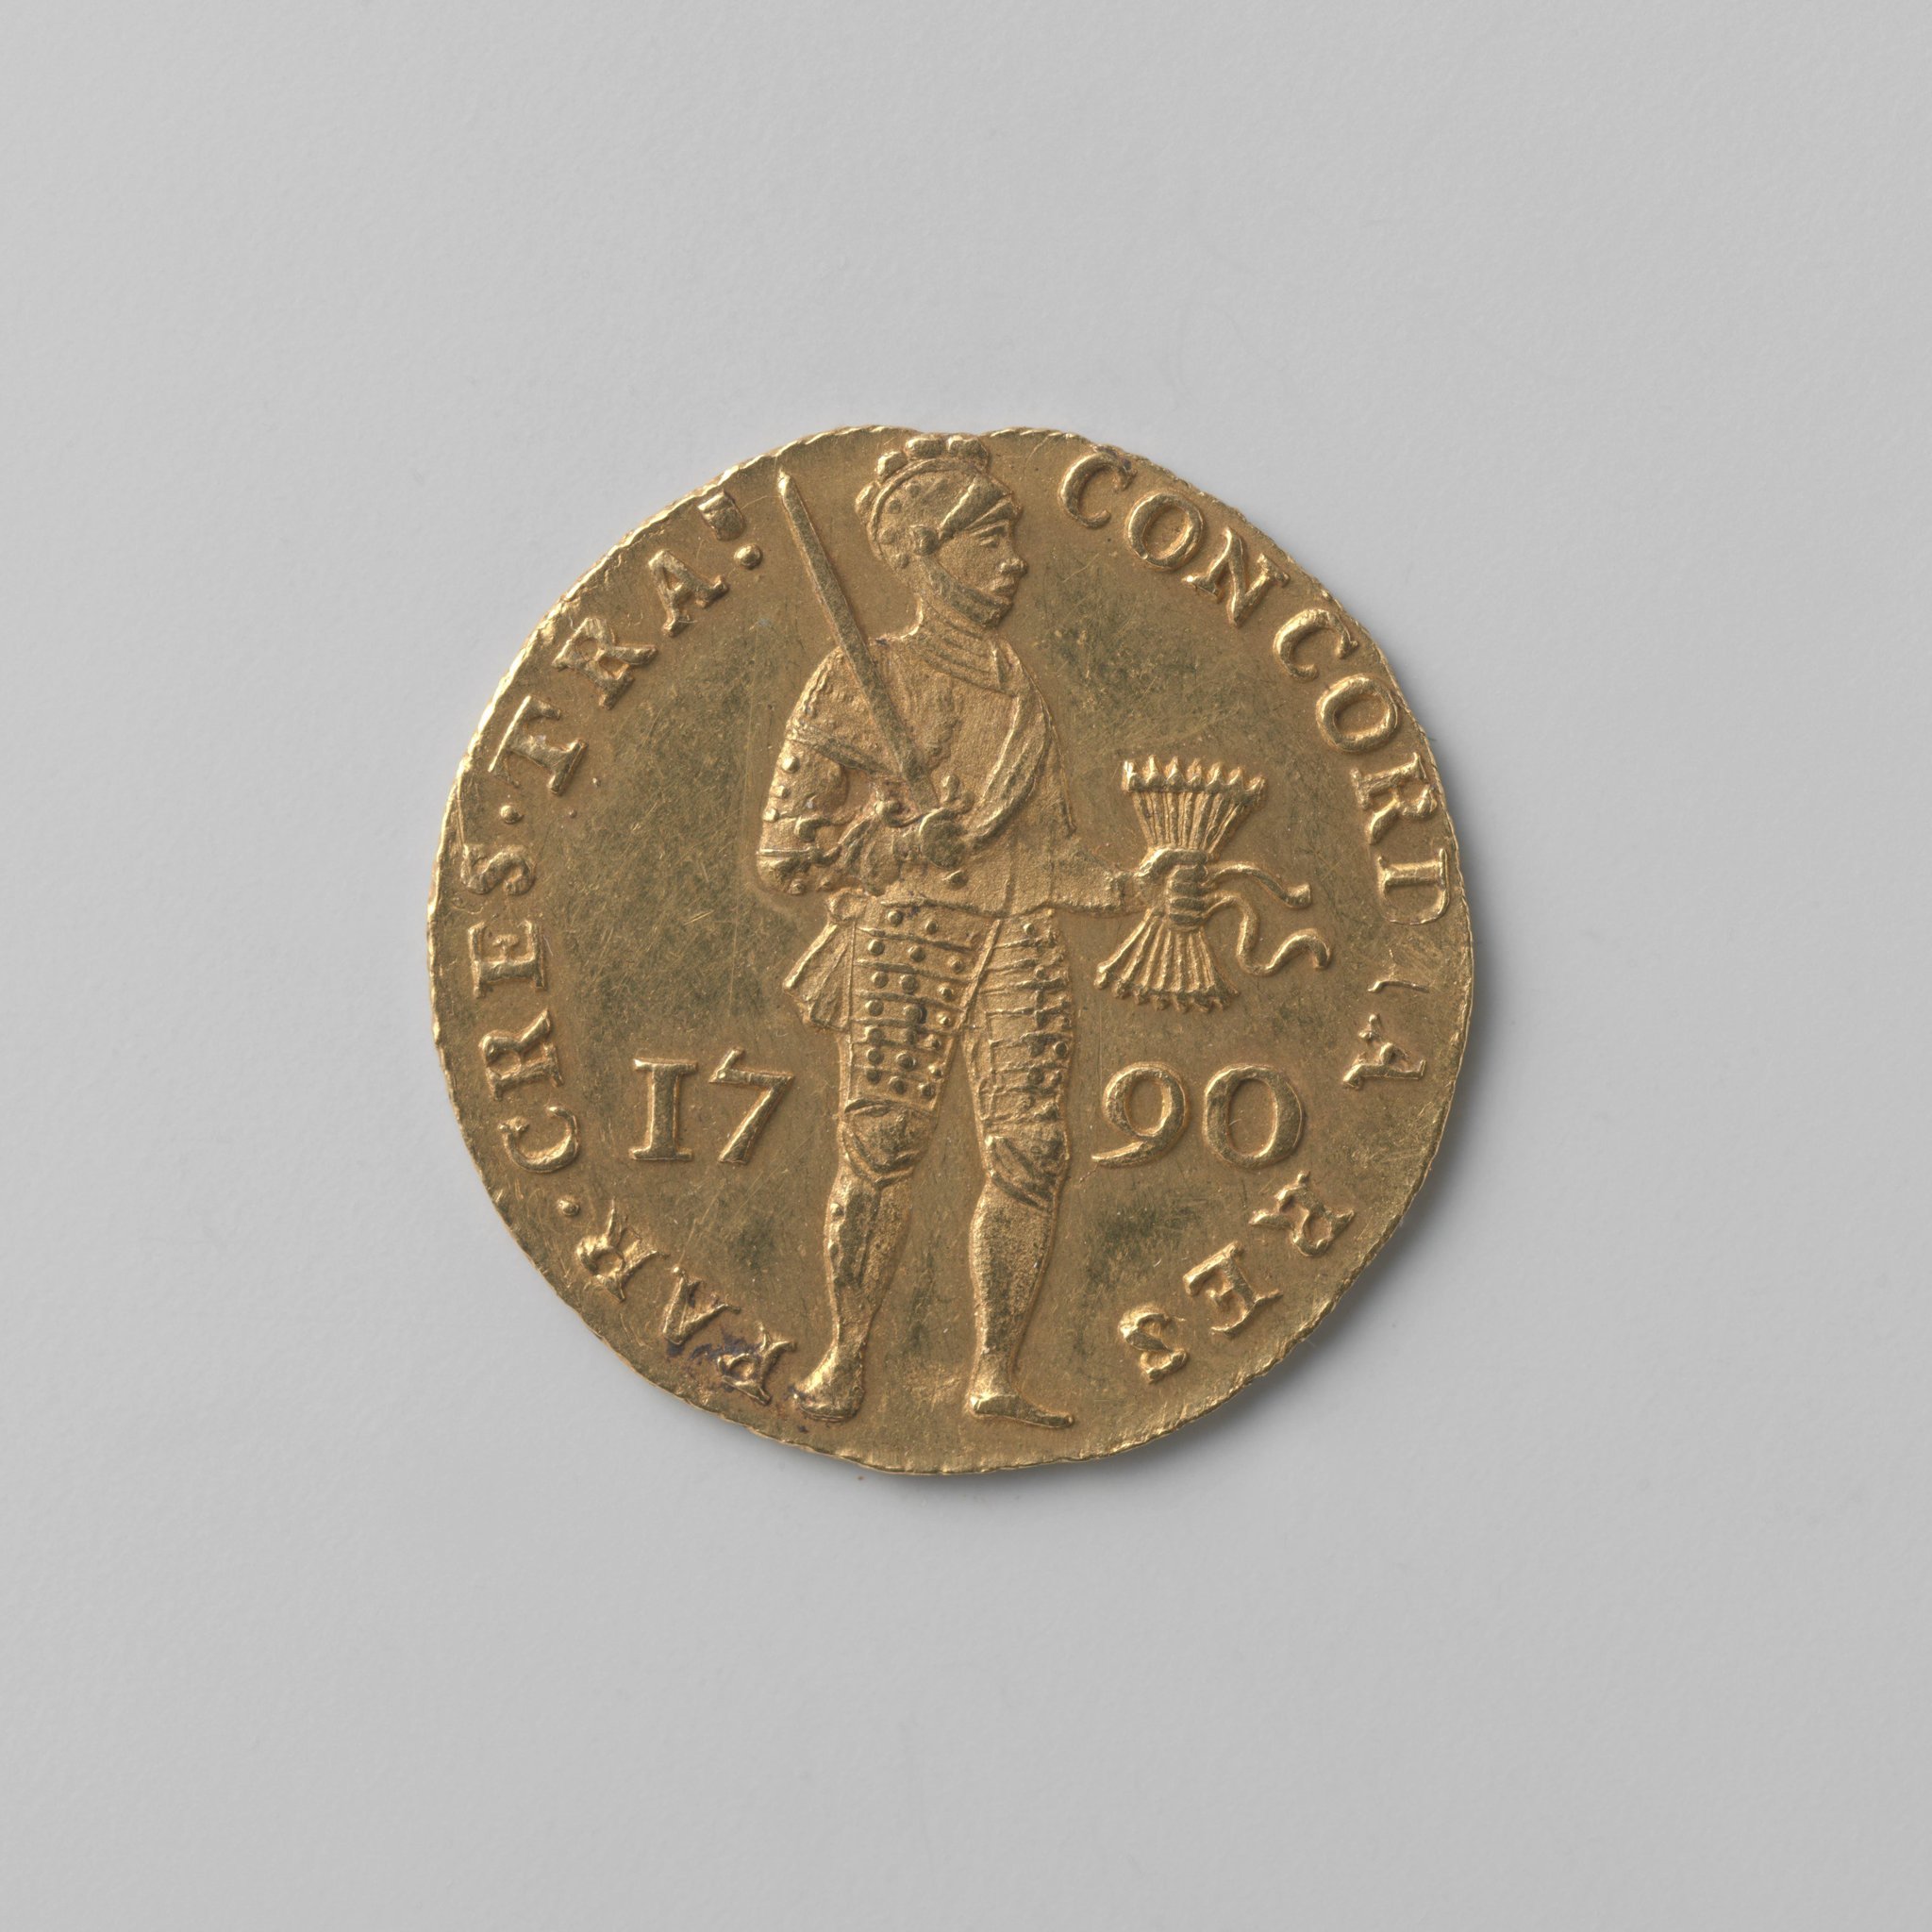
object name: coin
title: Utrecht, dukaat, 1790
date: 1790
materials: gold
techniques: striking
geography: utrecht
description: Gouden munt. Voorzijde: tussen jaartal staande ridder naar rechts. In rechterhand zwaard, in linkerhand pijlenbundel. Keerzijde: in versierd vierkant vijfregelig opschrift. Kabelrand.